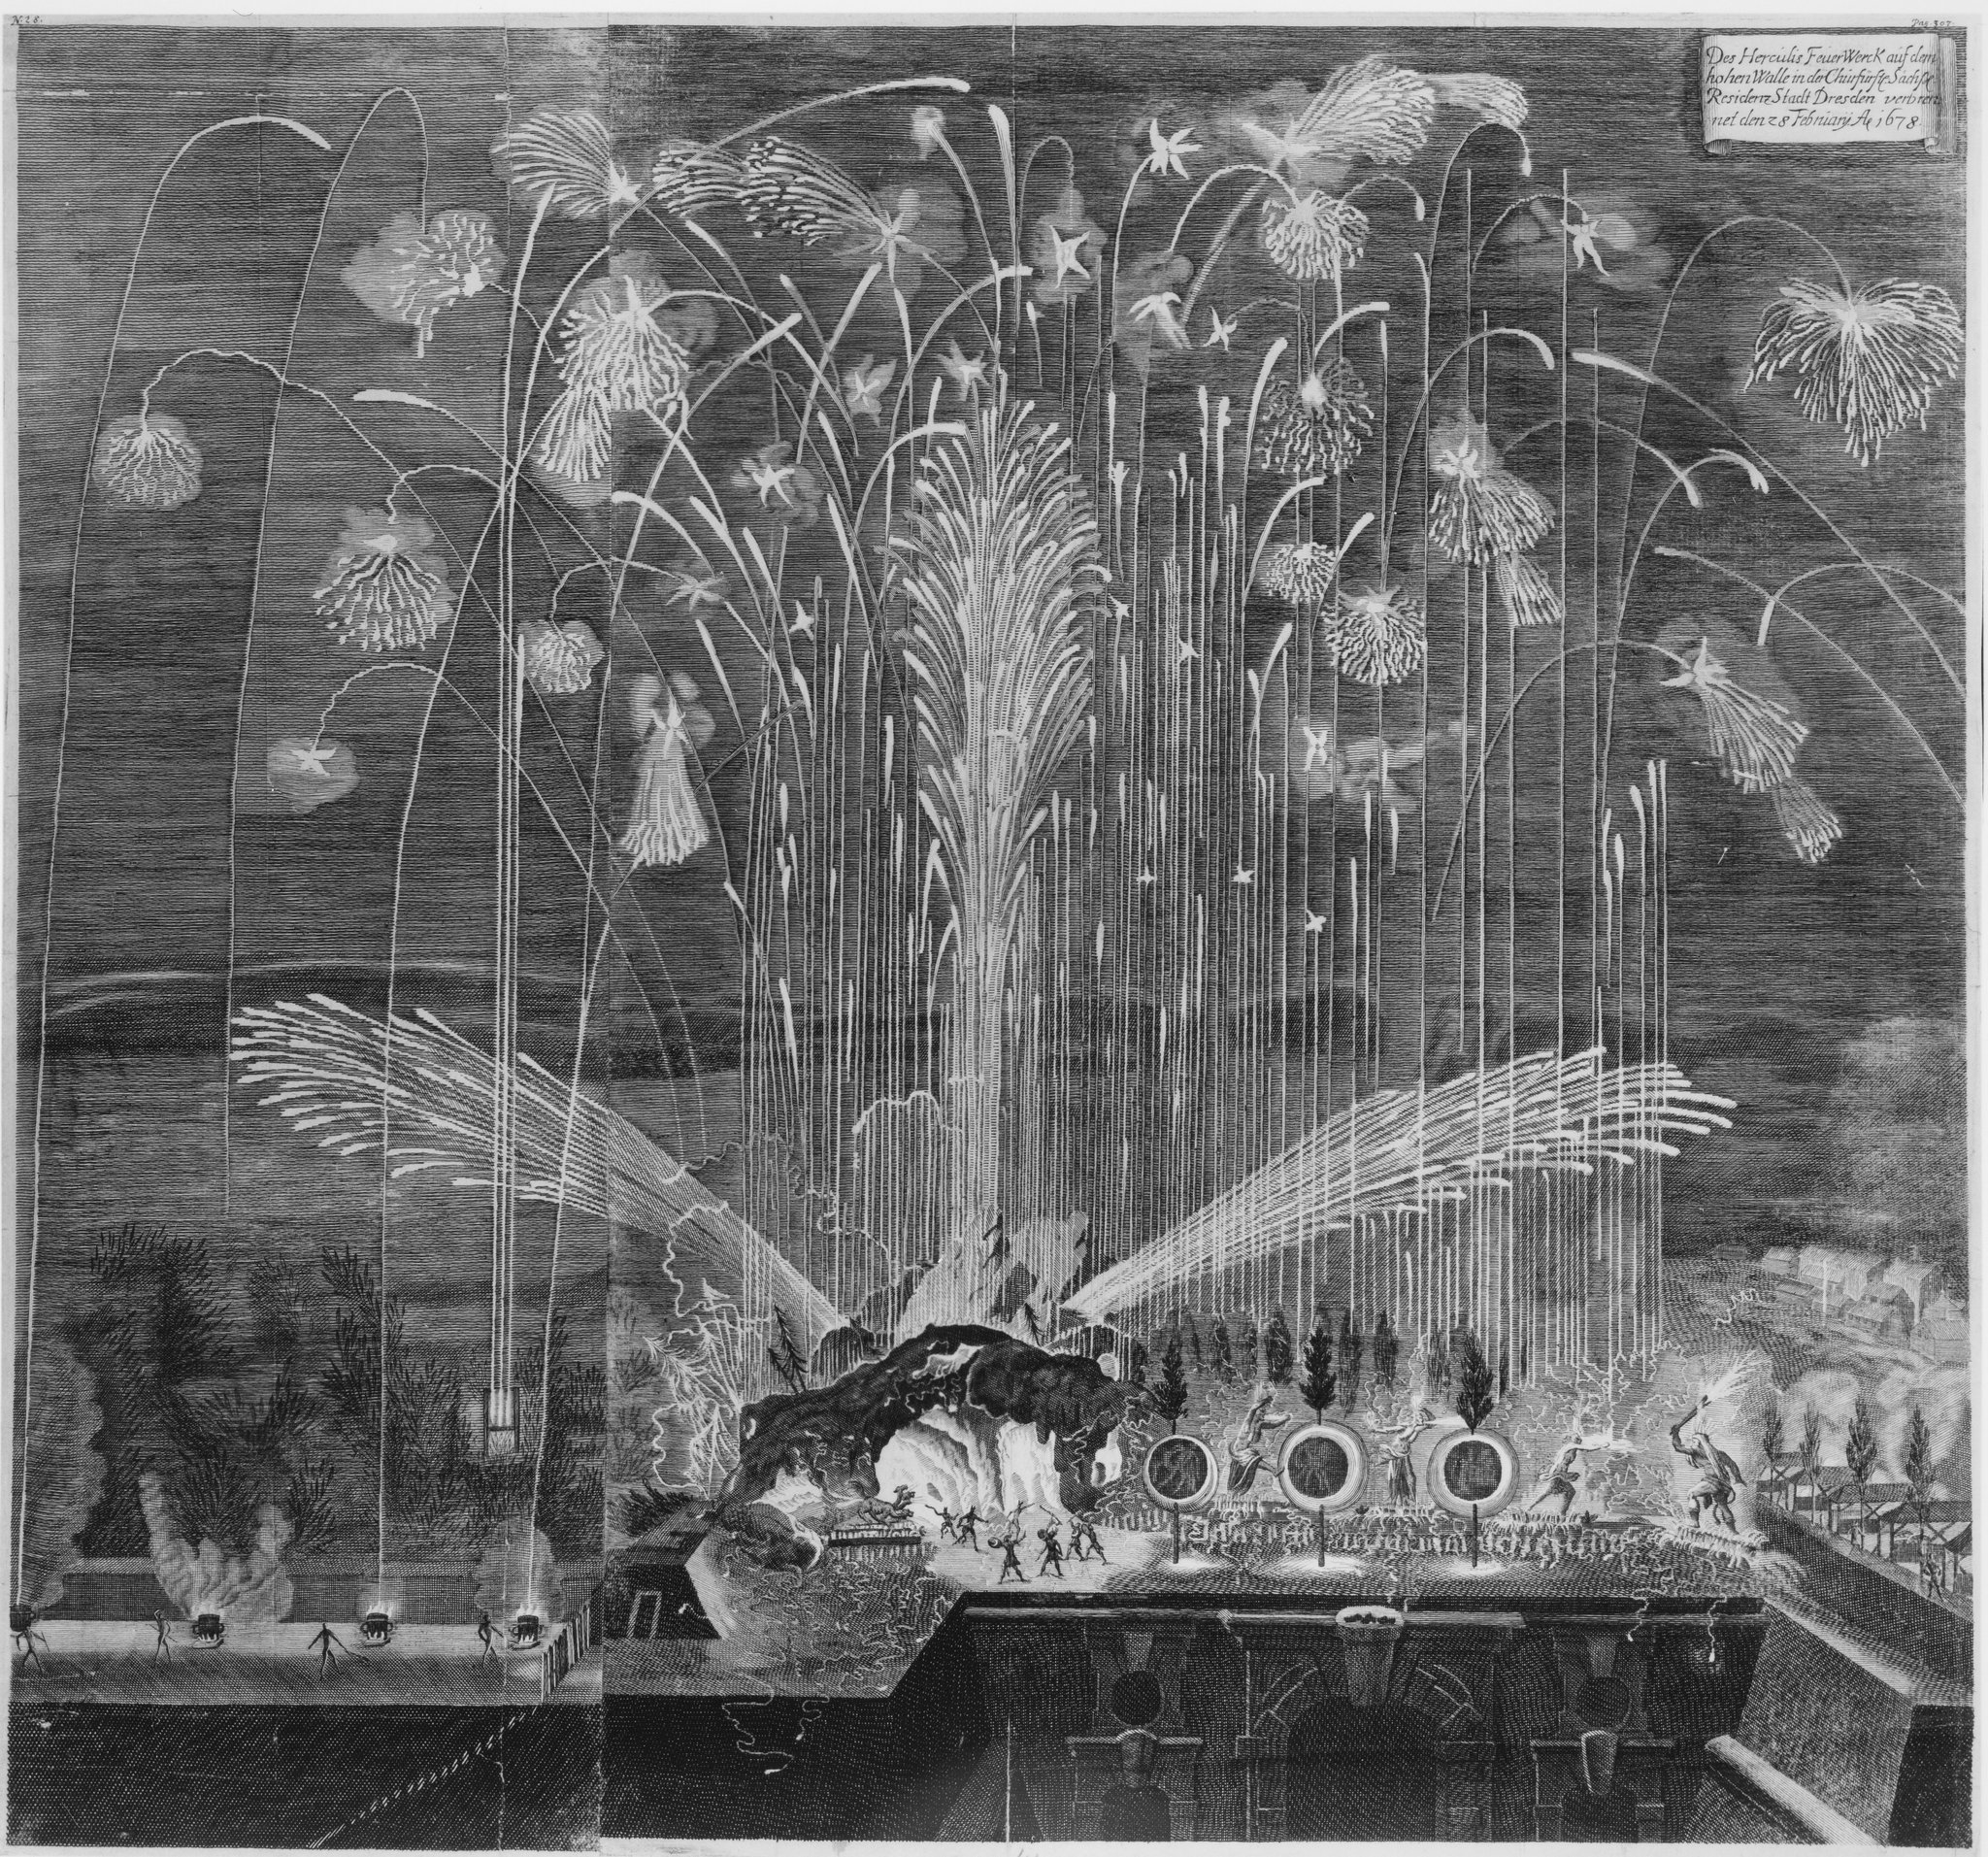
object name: print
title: Festival for the Family of the Elector of Saxony, Dresden, February 28, 1678: Hercules Fireworks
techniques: engraving, etching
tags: fireworks